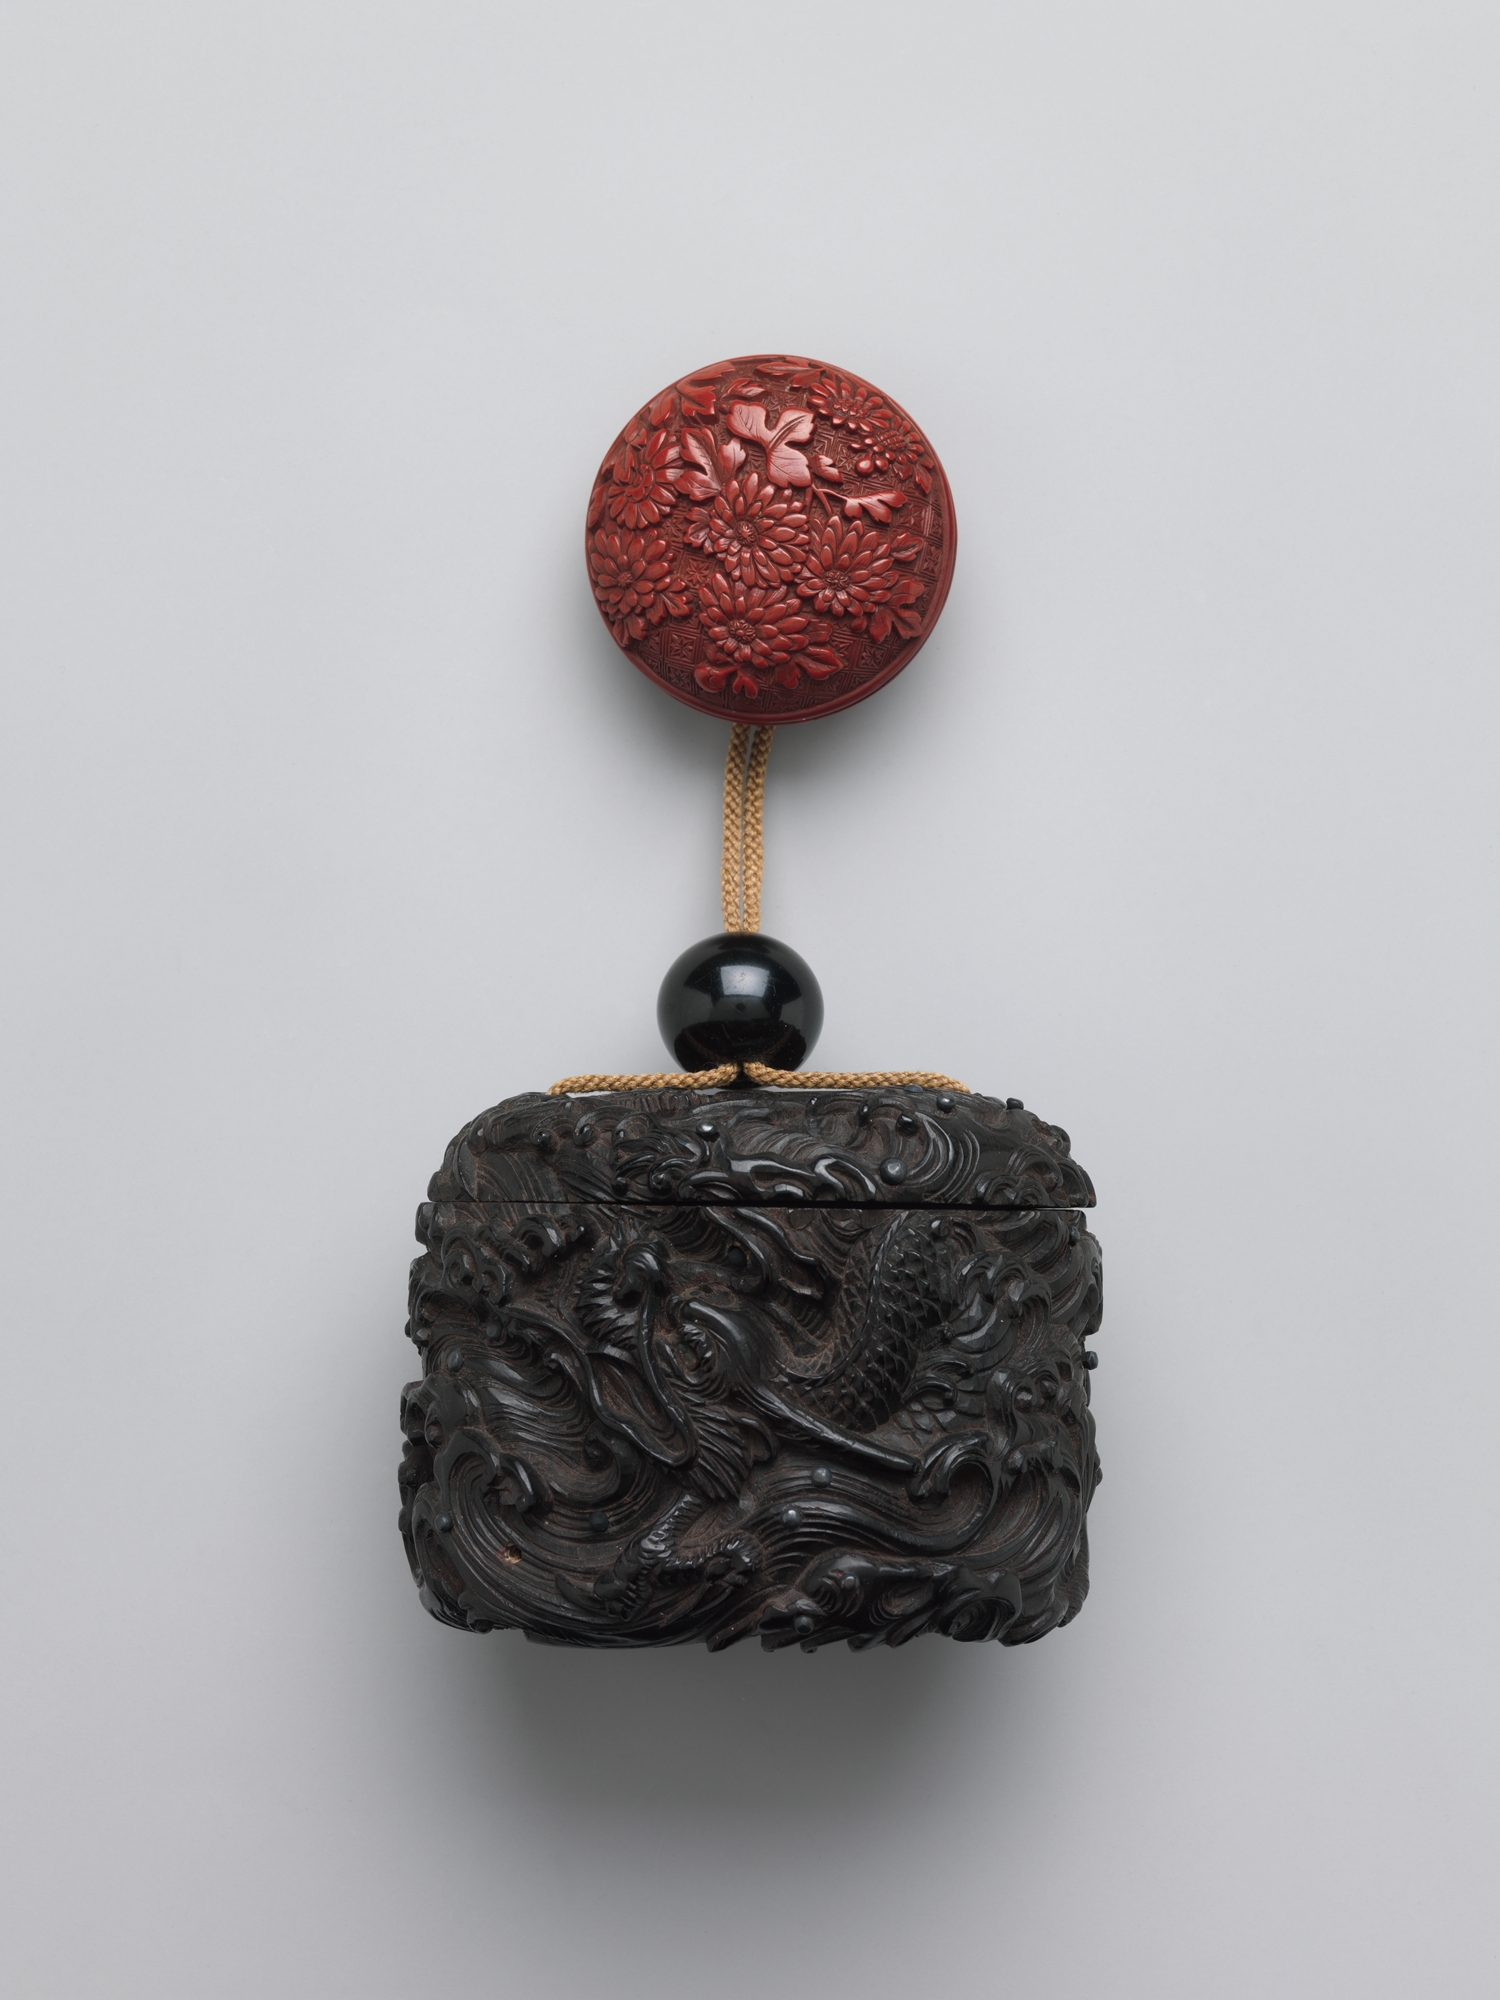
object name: tobacco pouch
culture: japanese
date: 1850-1880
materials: lacquer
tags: dragons,flowers